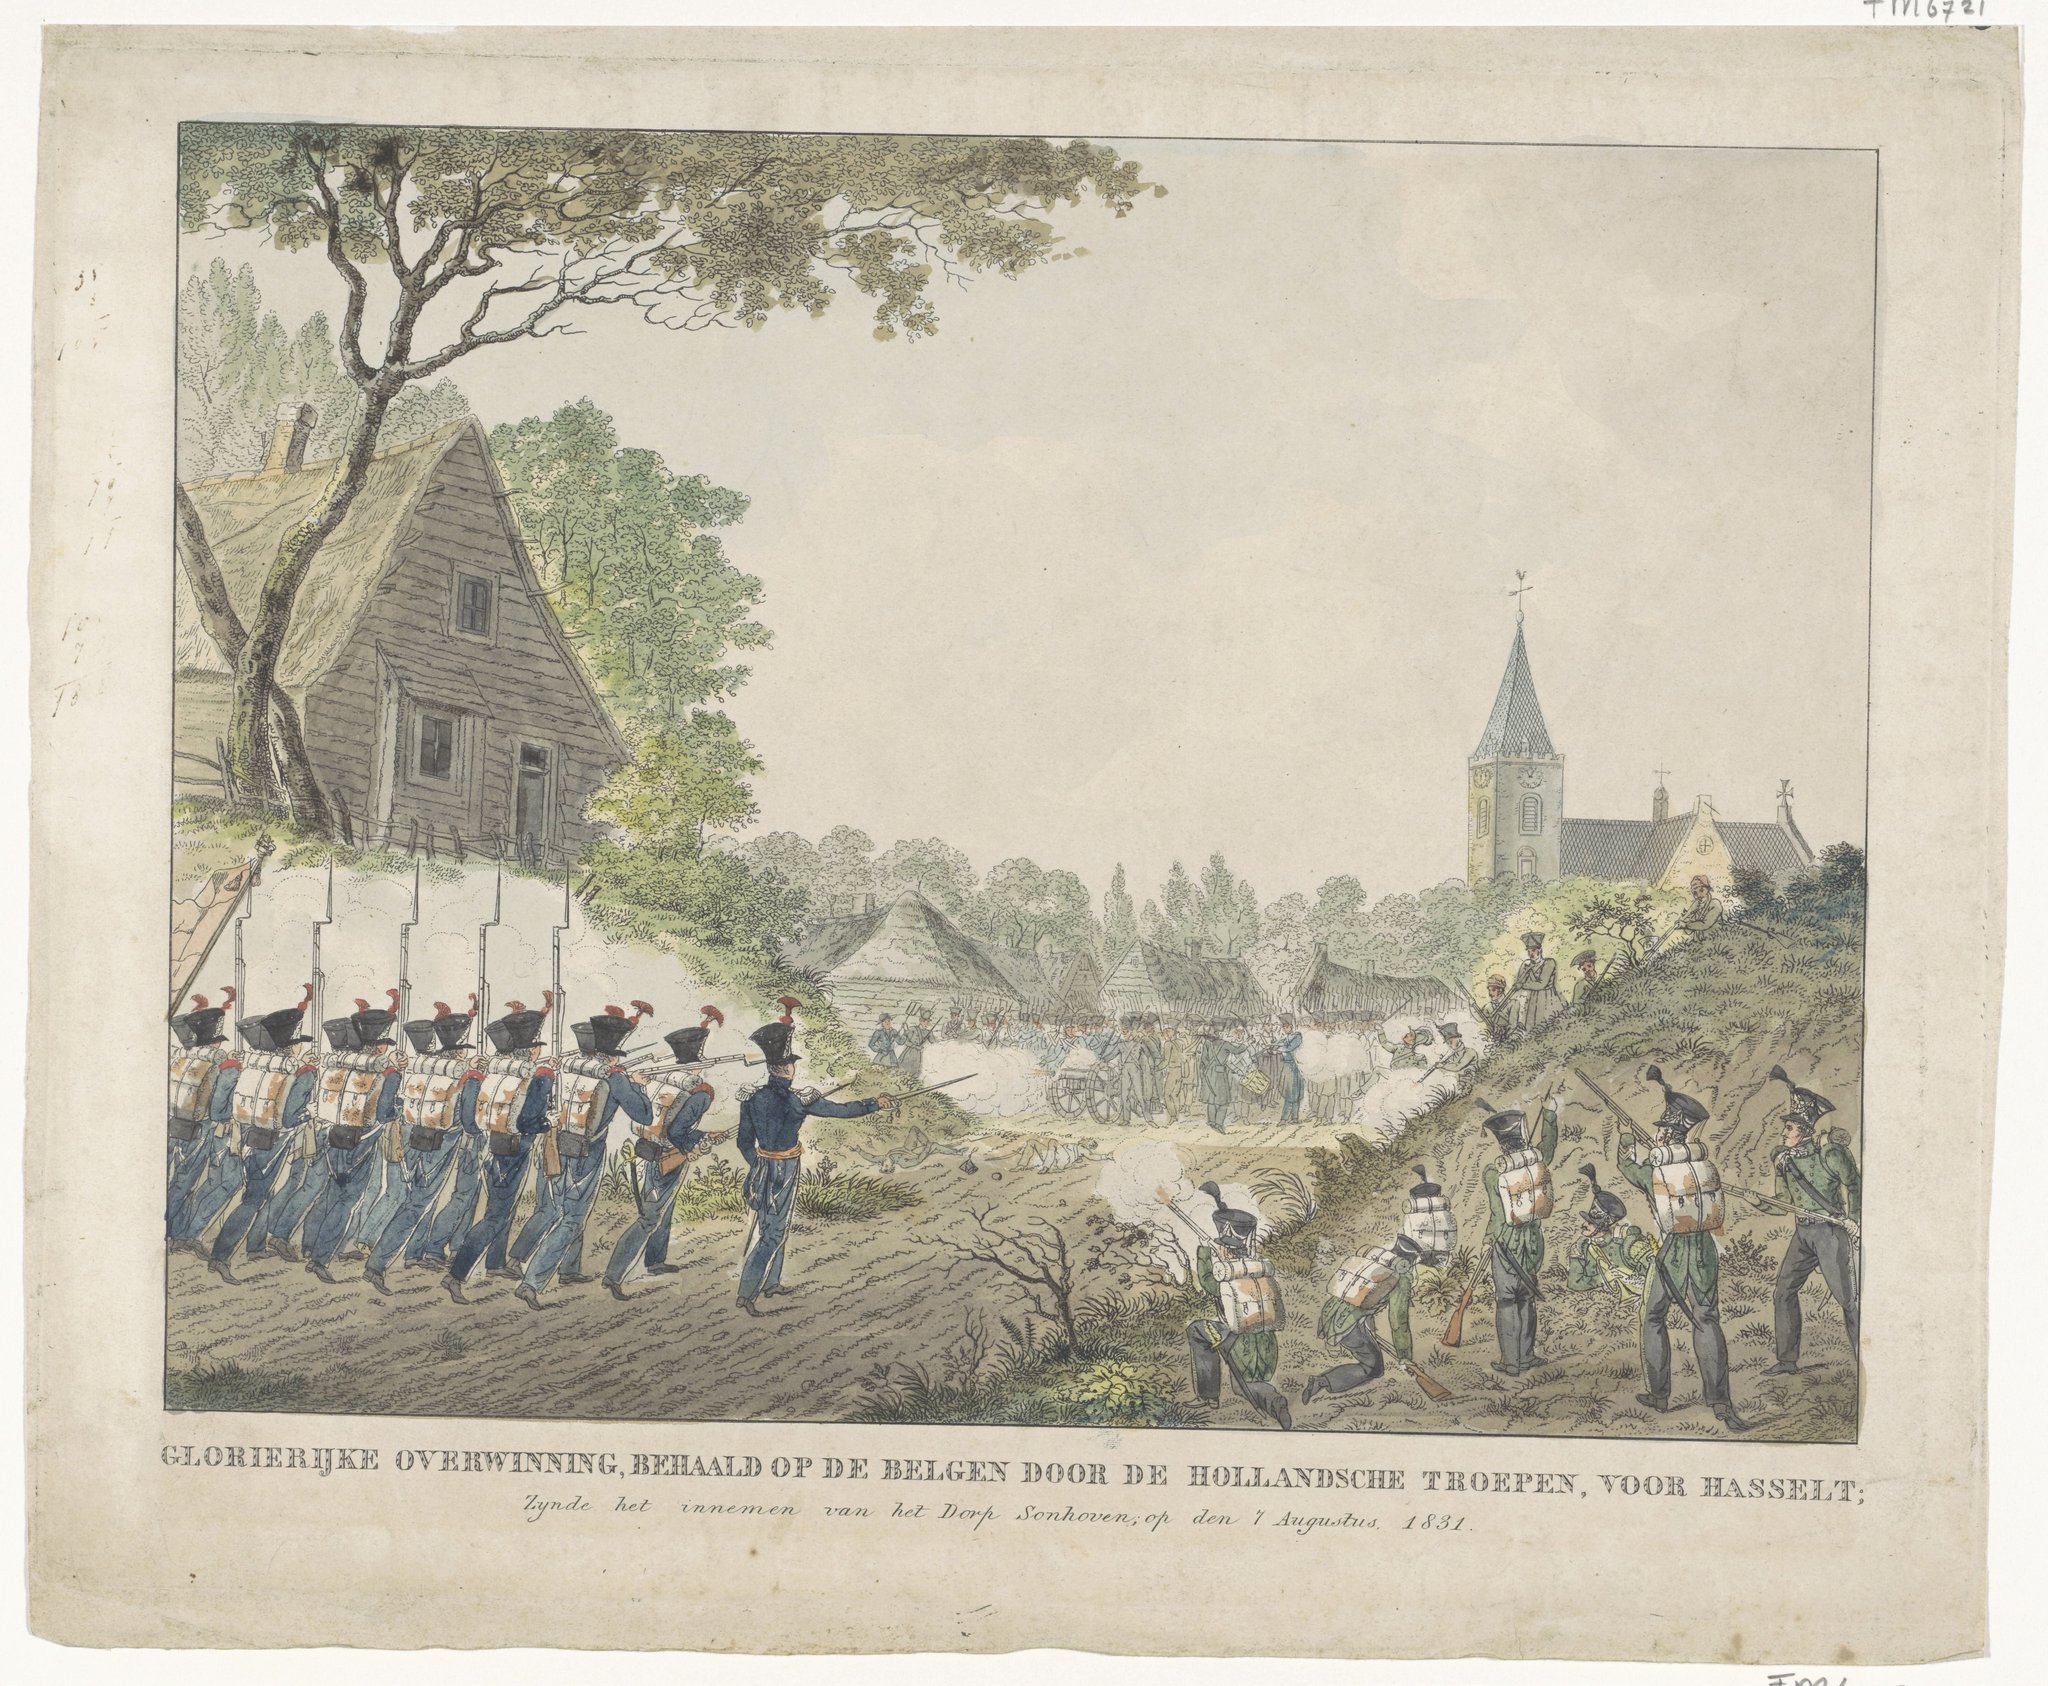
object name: print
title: Verovering van Sonhoven, 1831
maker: Anonymous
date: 1831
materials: paper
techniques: etching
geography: netherlands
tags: battle (+ land forces)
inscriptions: collector's mark: Lugt 2228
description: Verovering van het Belgische dorp Zonhoven bij Hasselt door Nederlandse troepen, 7 augustus 1831.